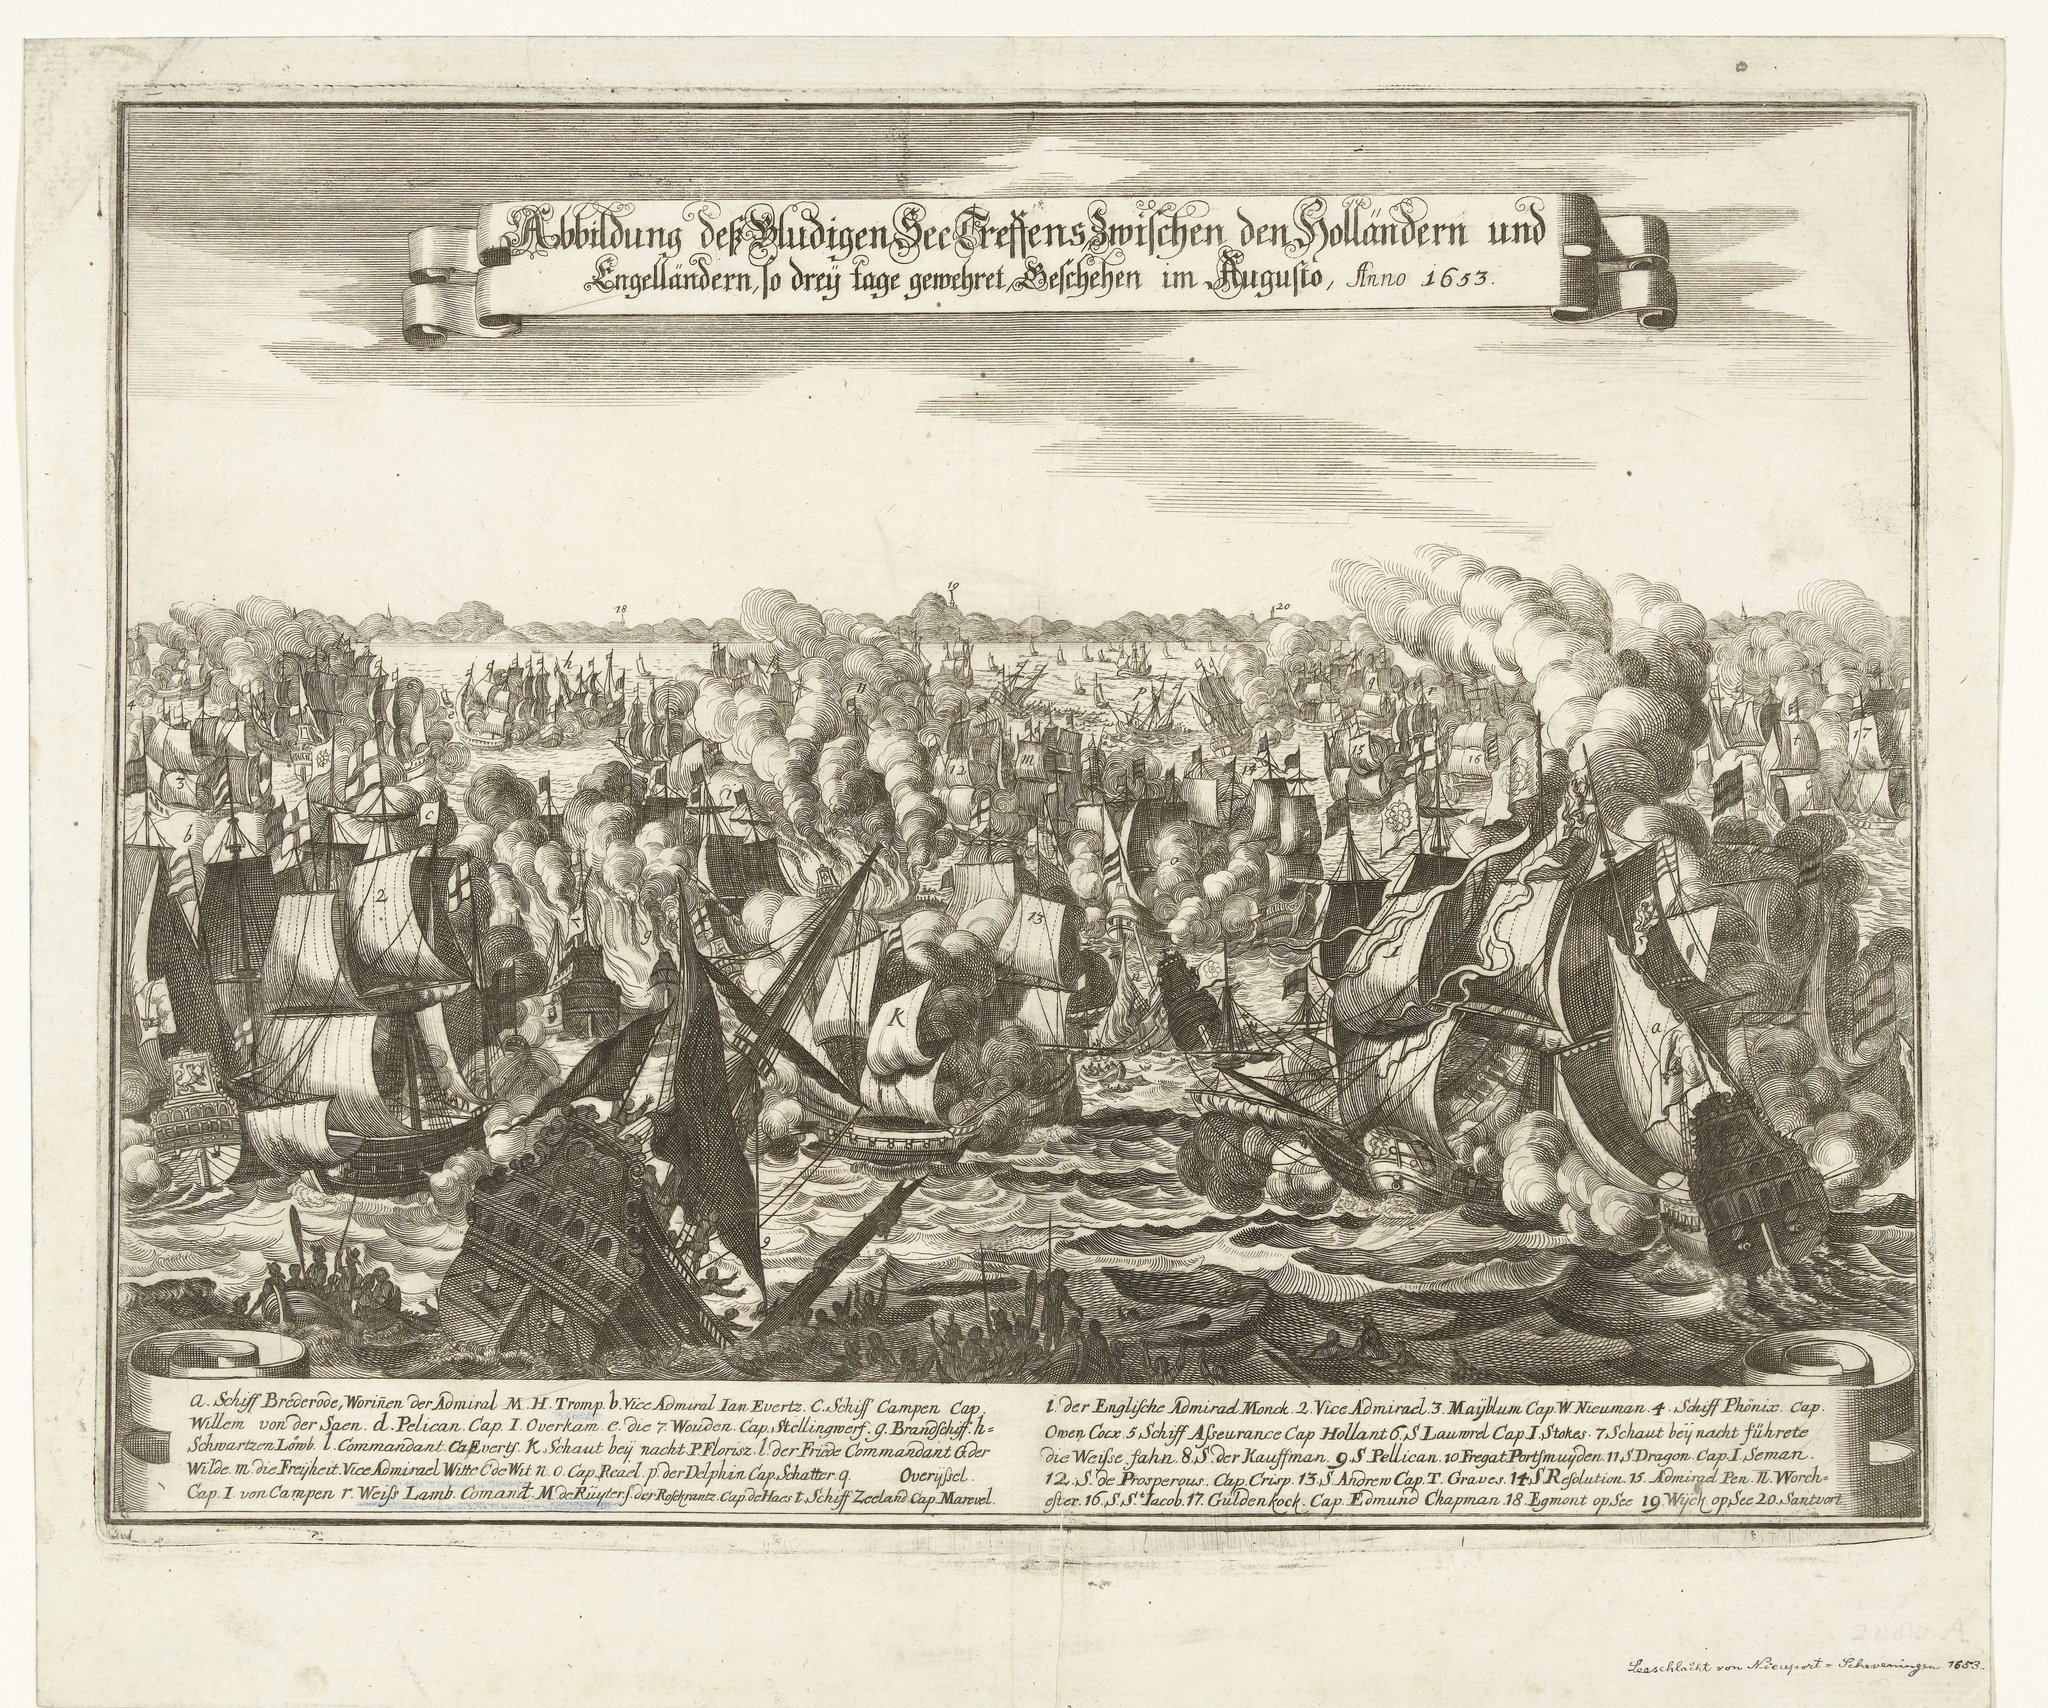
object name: print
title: Zeeslag bij Terheide, 1653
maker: Anonymous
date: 1653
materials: paper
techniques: etching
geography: germany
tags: maarten harpertszoon tromp, battle (+ naval force), battle of scheveningen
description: De zeeslag bij Terheide in de Eerste Engelse Oorlog tussen de Staatse vloot onder Maarten Tromp en de Engelse vloot onder George Monck, 10 augustus 1653. Op een banderol het onderschrift met de legenda's a-t en 1-20 in het Duits.